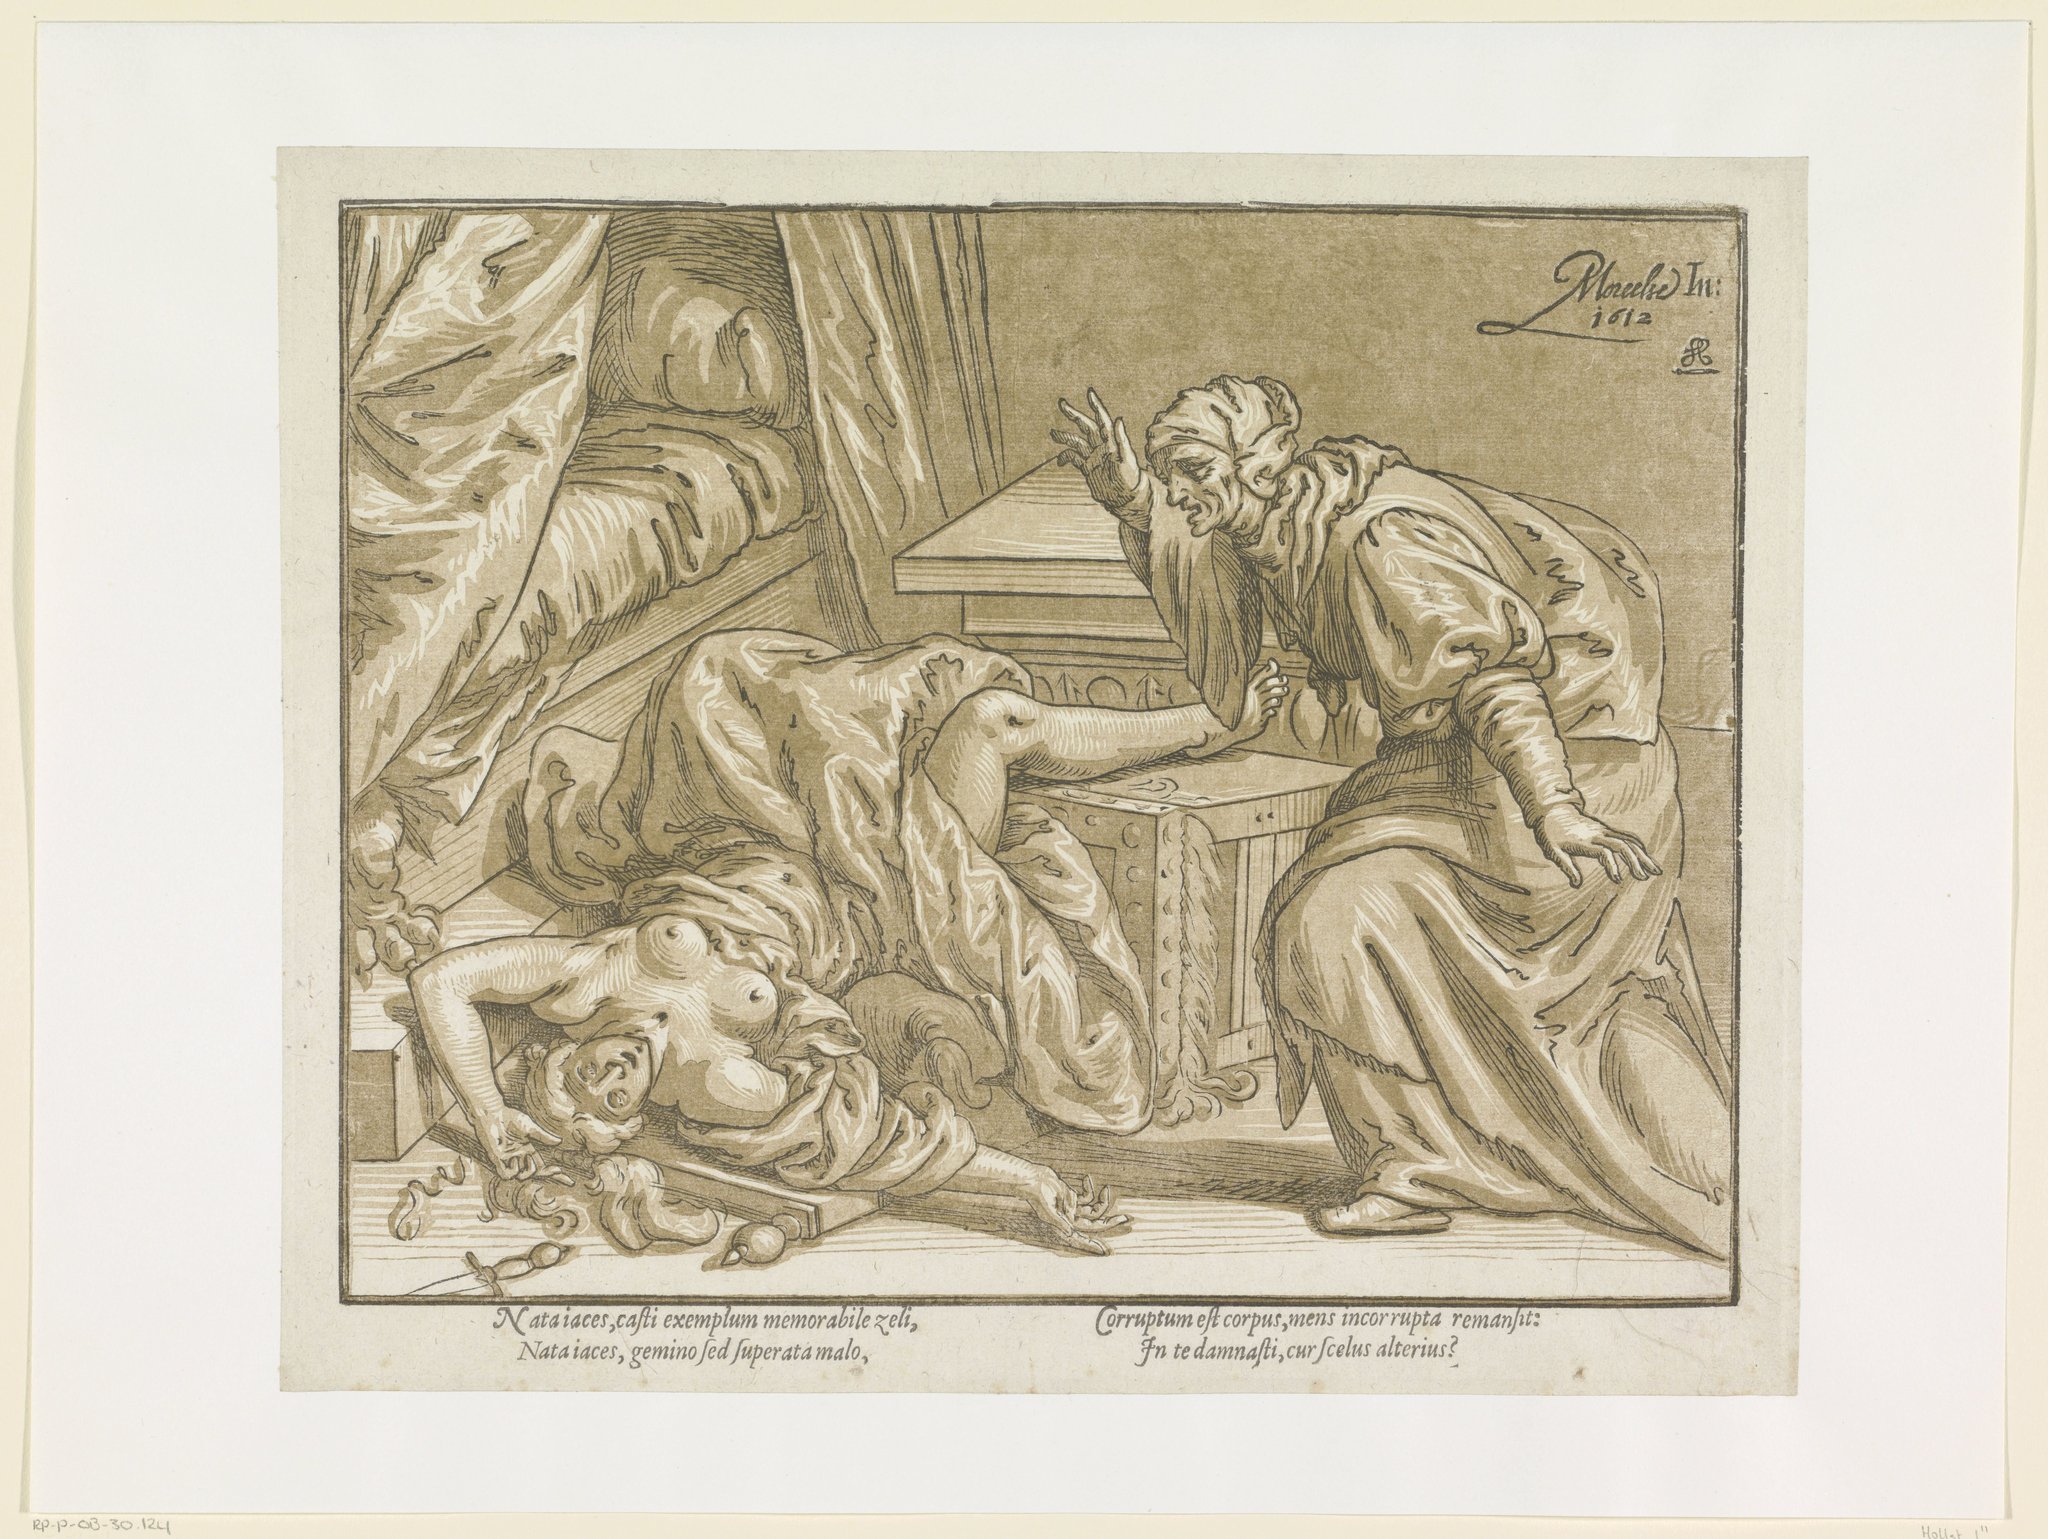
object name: print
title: Dood van Lucretia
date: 1612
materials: paper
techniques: woodcut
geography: netherlands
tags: death of lucretia: she commits suicide by stabbing herself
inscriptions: collector's mark: Lugt 240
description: Lucretia pleegt zelfmoord door zich met een dolk te doorsteken, omdat ze de schaamte na de verkrachting door Sextus niet meer aan kan. Haar naakte lichaam ligt op de grond naast haar bed. Haar man Collatinus rent op haar af. In de ondermarge twee kolommen met elk twee regels Latijnse tekst.